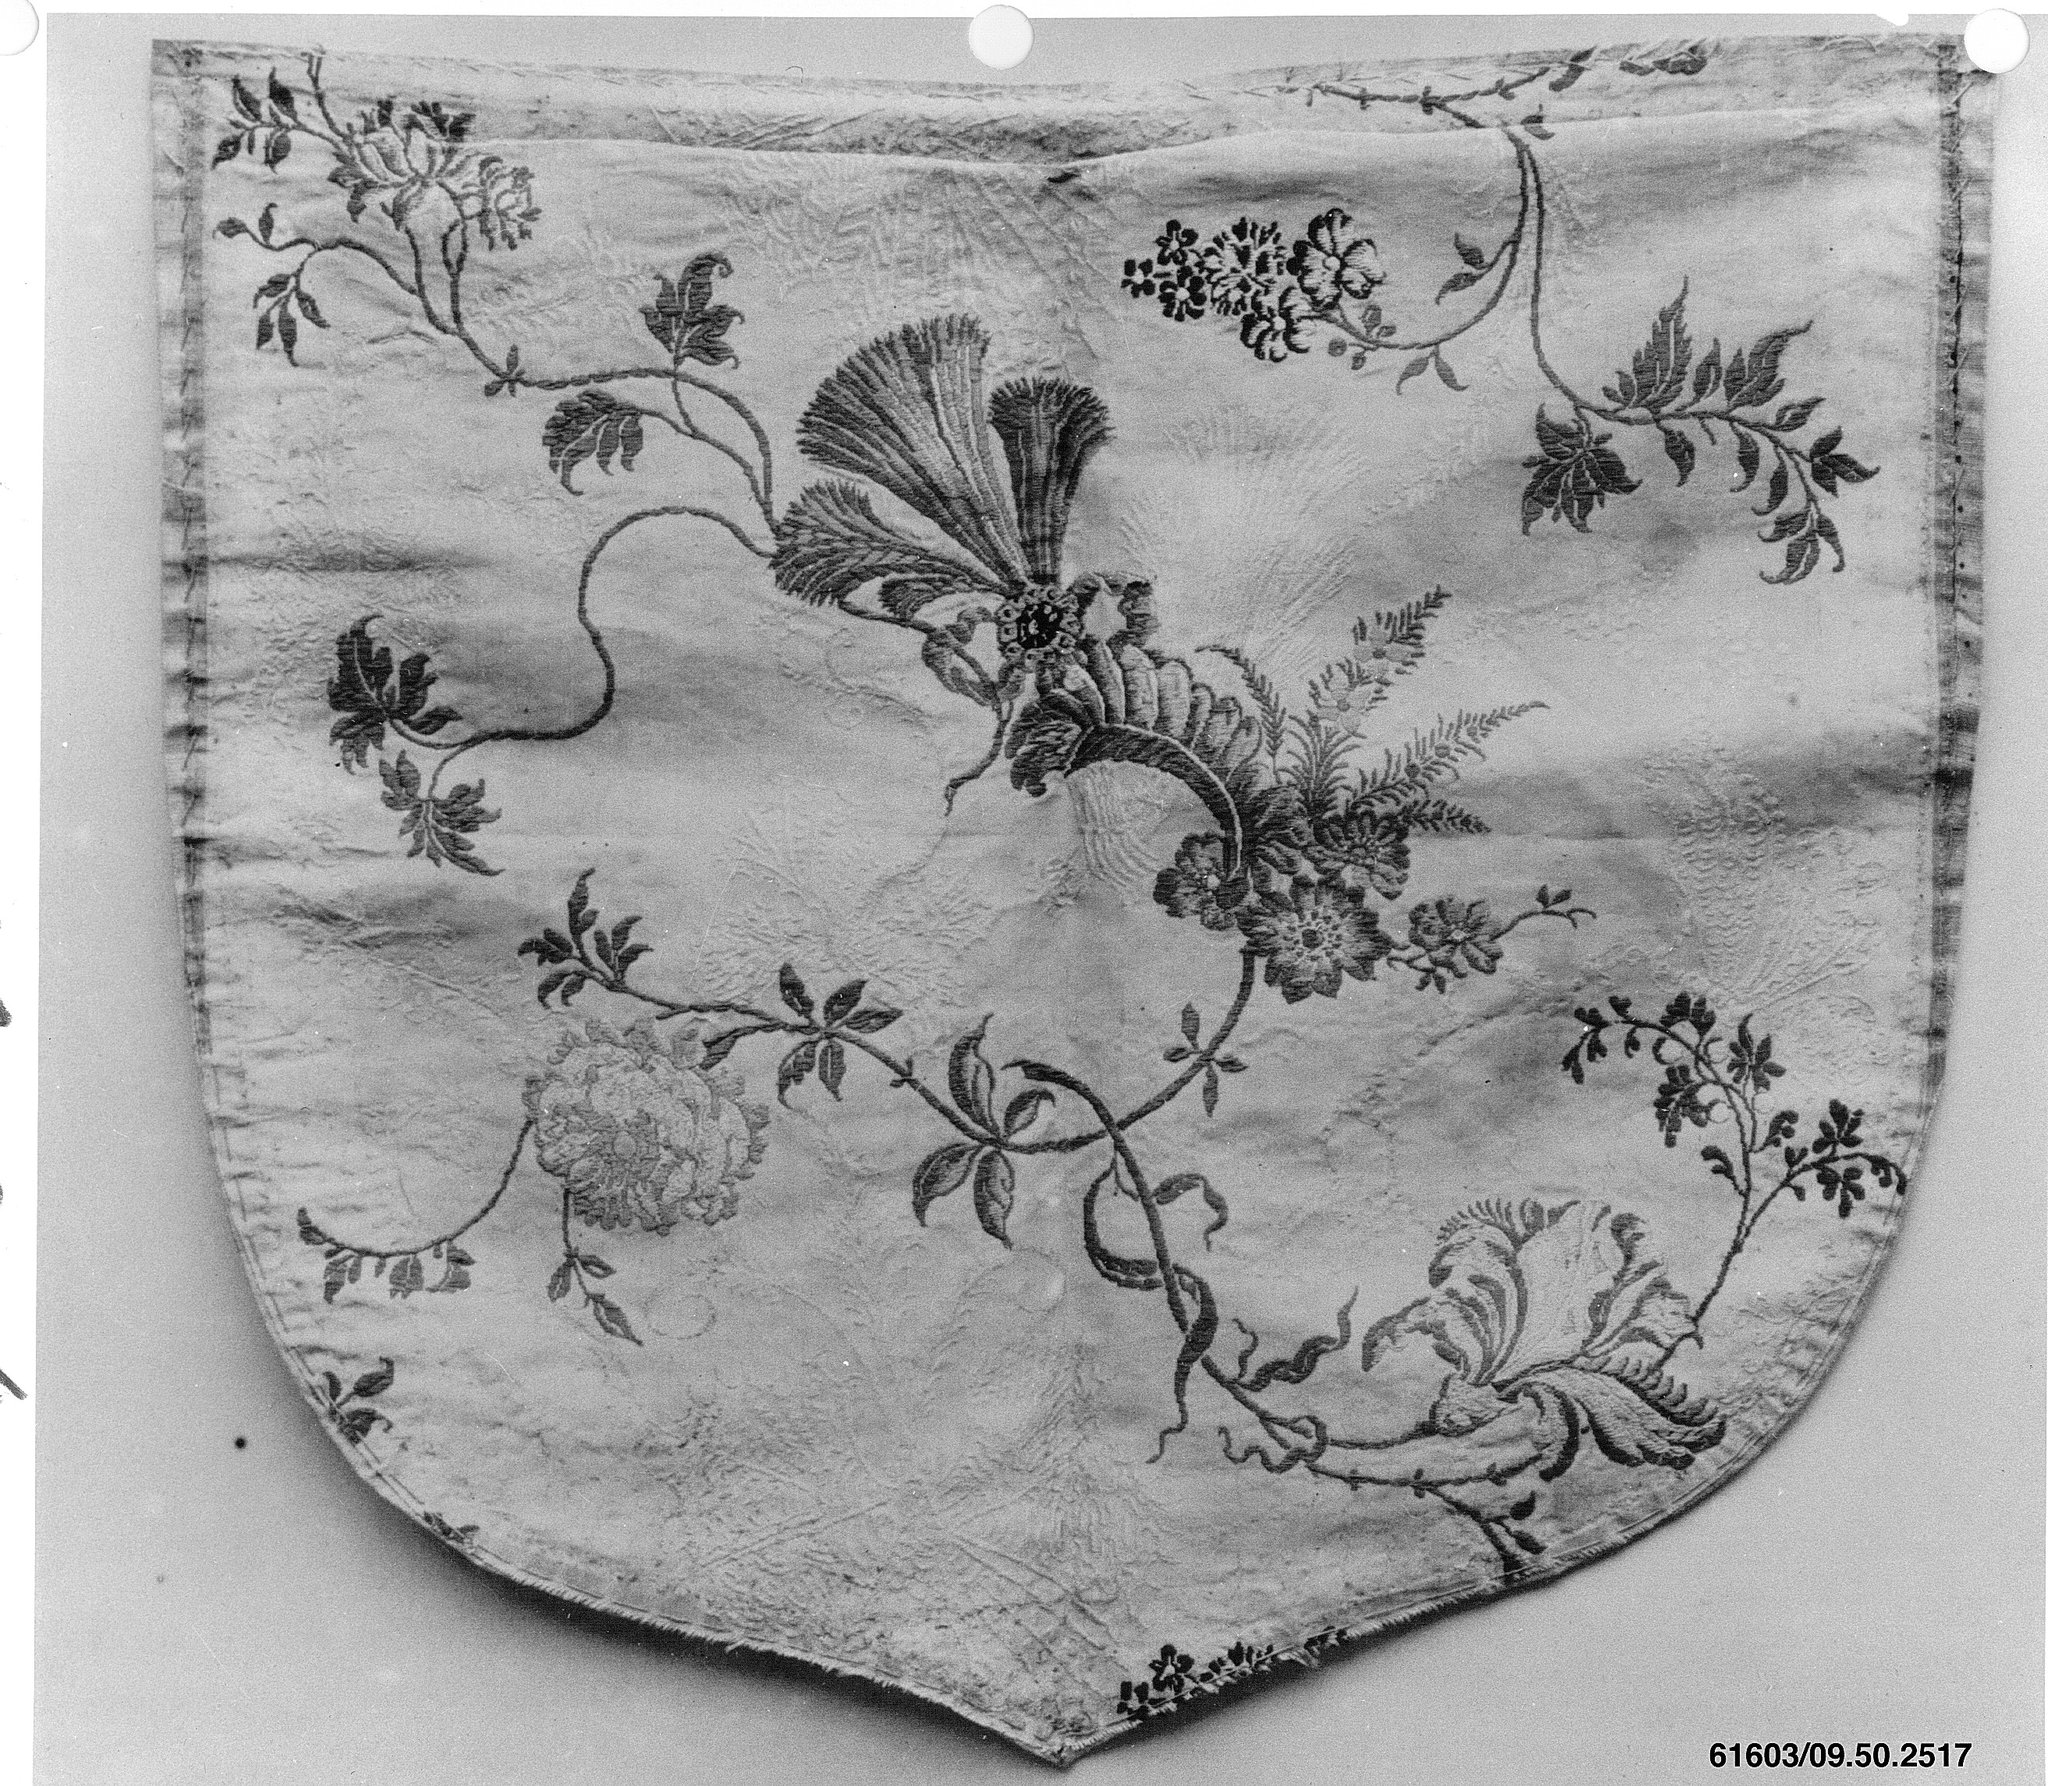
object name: piece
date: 1750-1760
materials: silk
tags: flowers,leaves